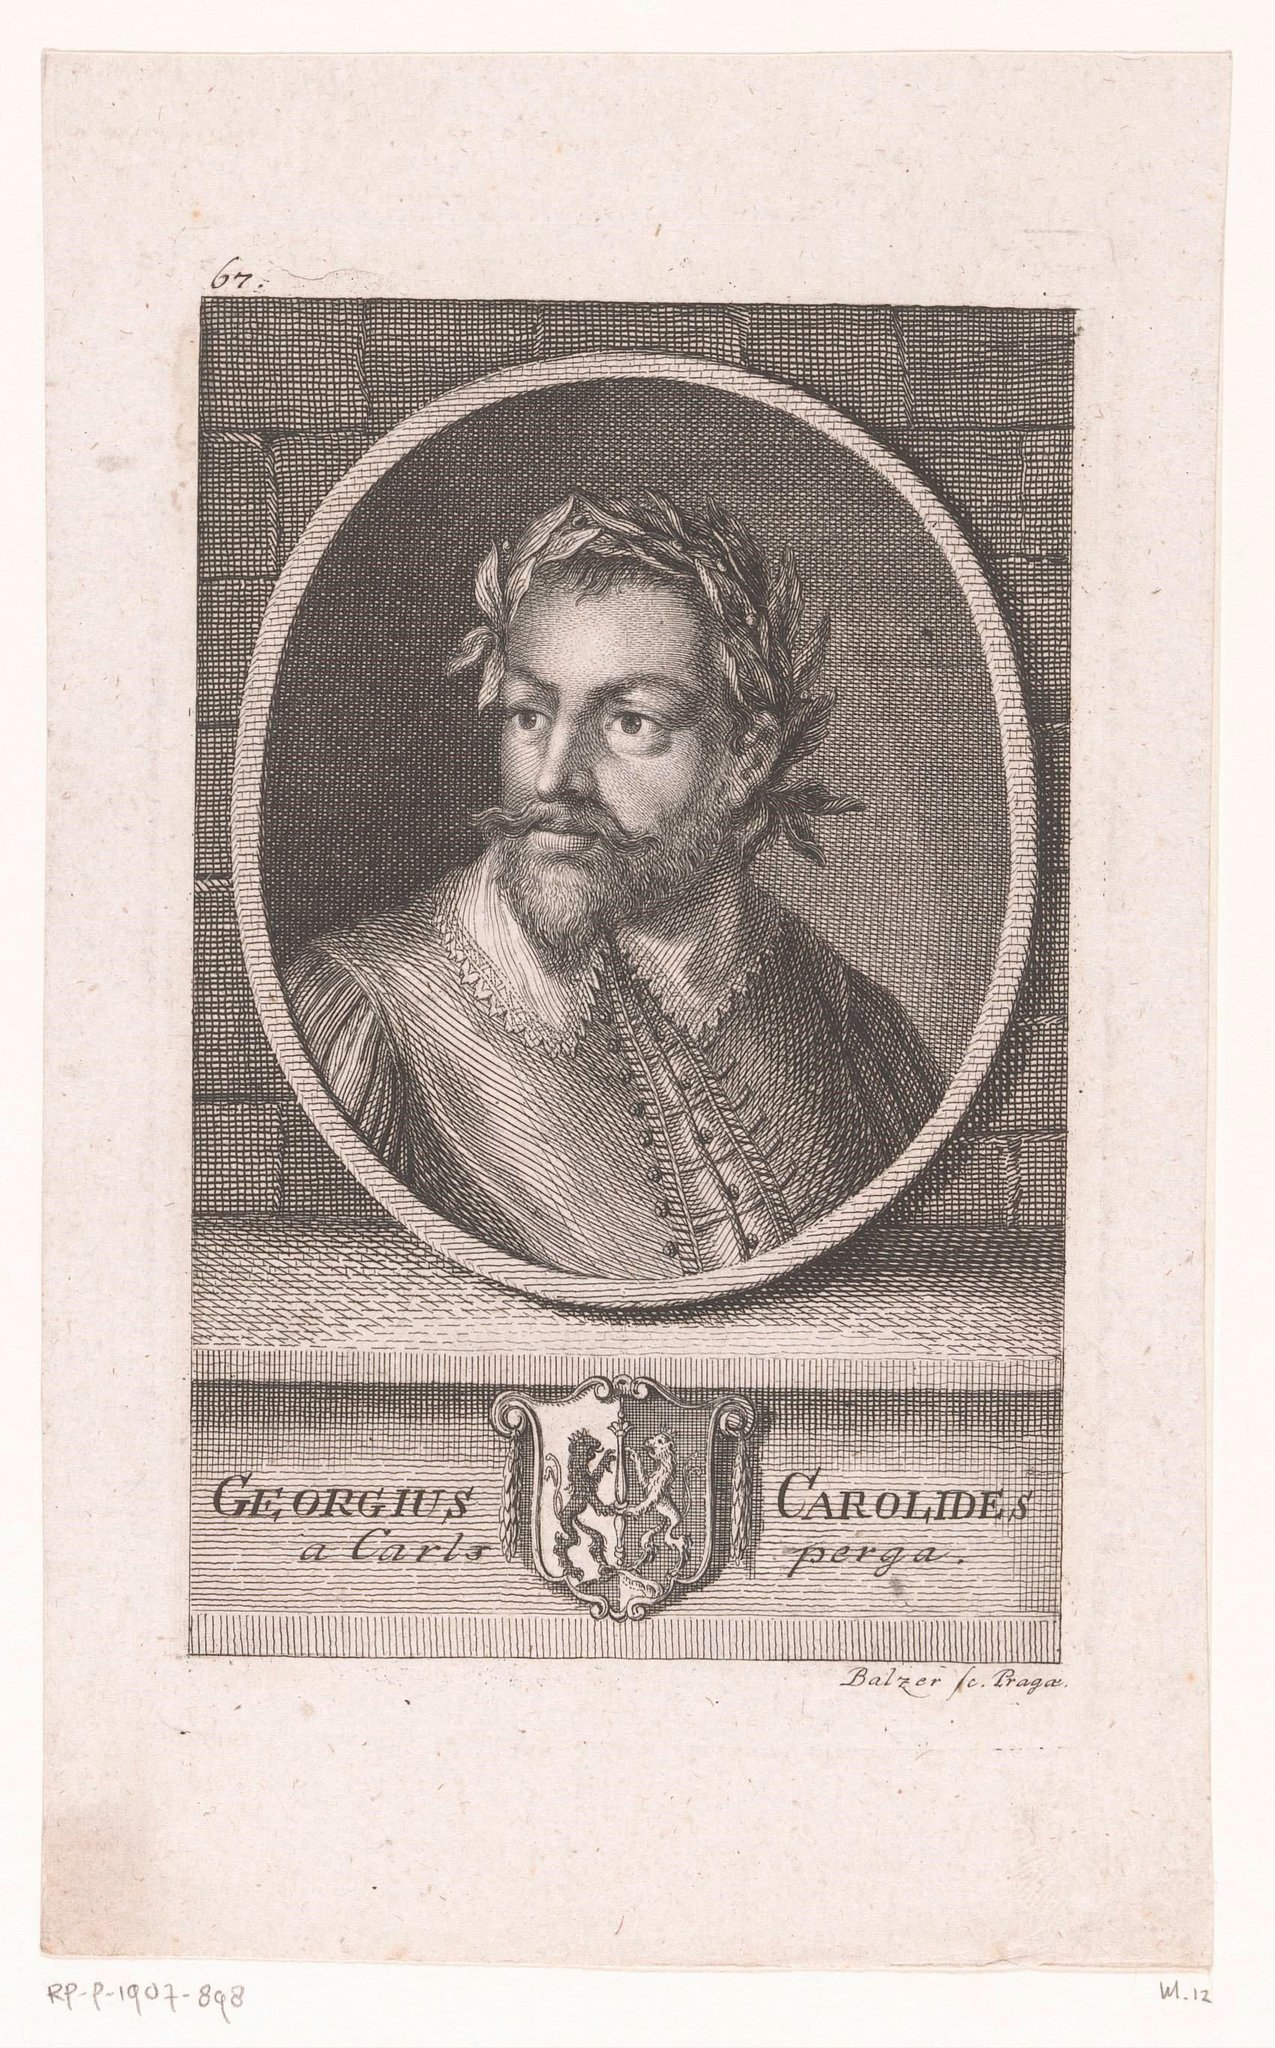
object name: print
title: Portret van Georg Carolides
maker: jan balzer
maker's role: print maker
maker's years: 1736-1799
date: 1746-1799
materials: paper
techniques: engraving, etching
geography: prague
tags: prague, historical persons, writer, poet, author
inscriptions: collector's mark: Lugt 2228